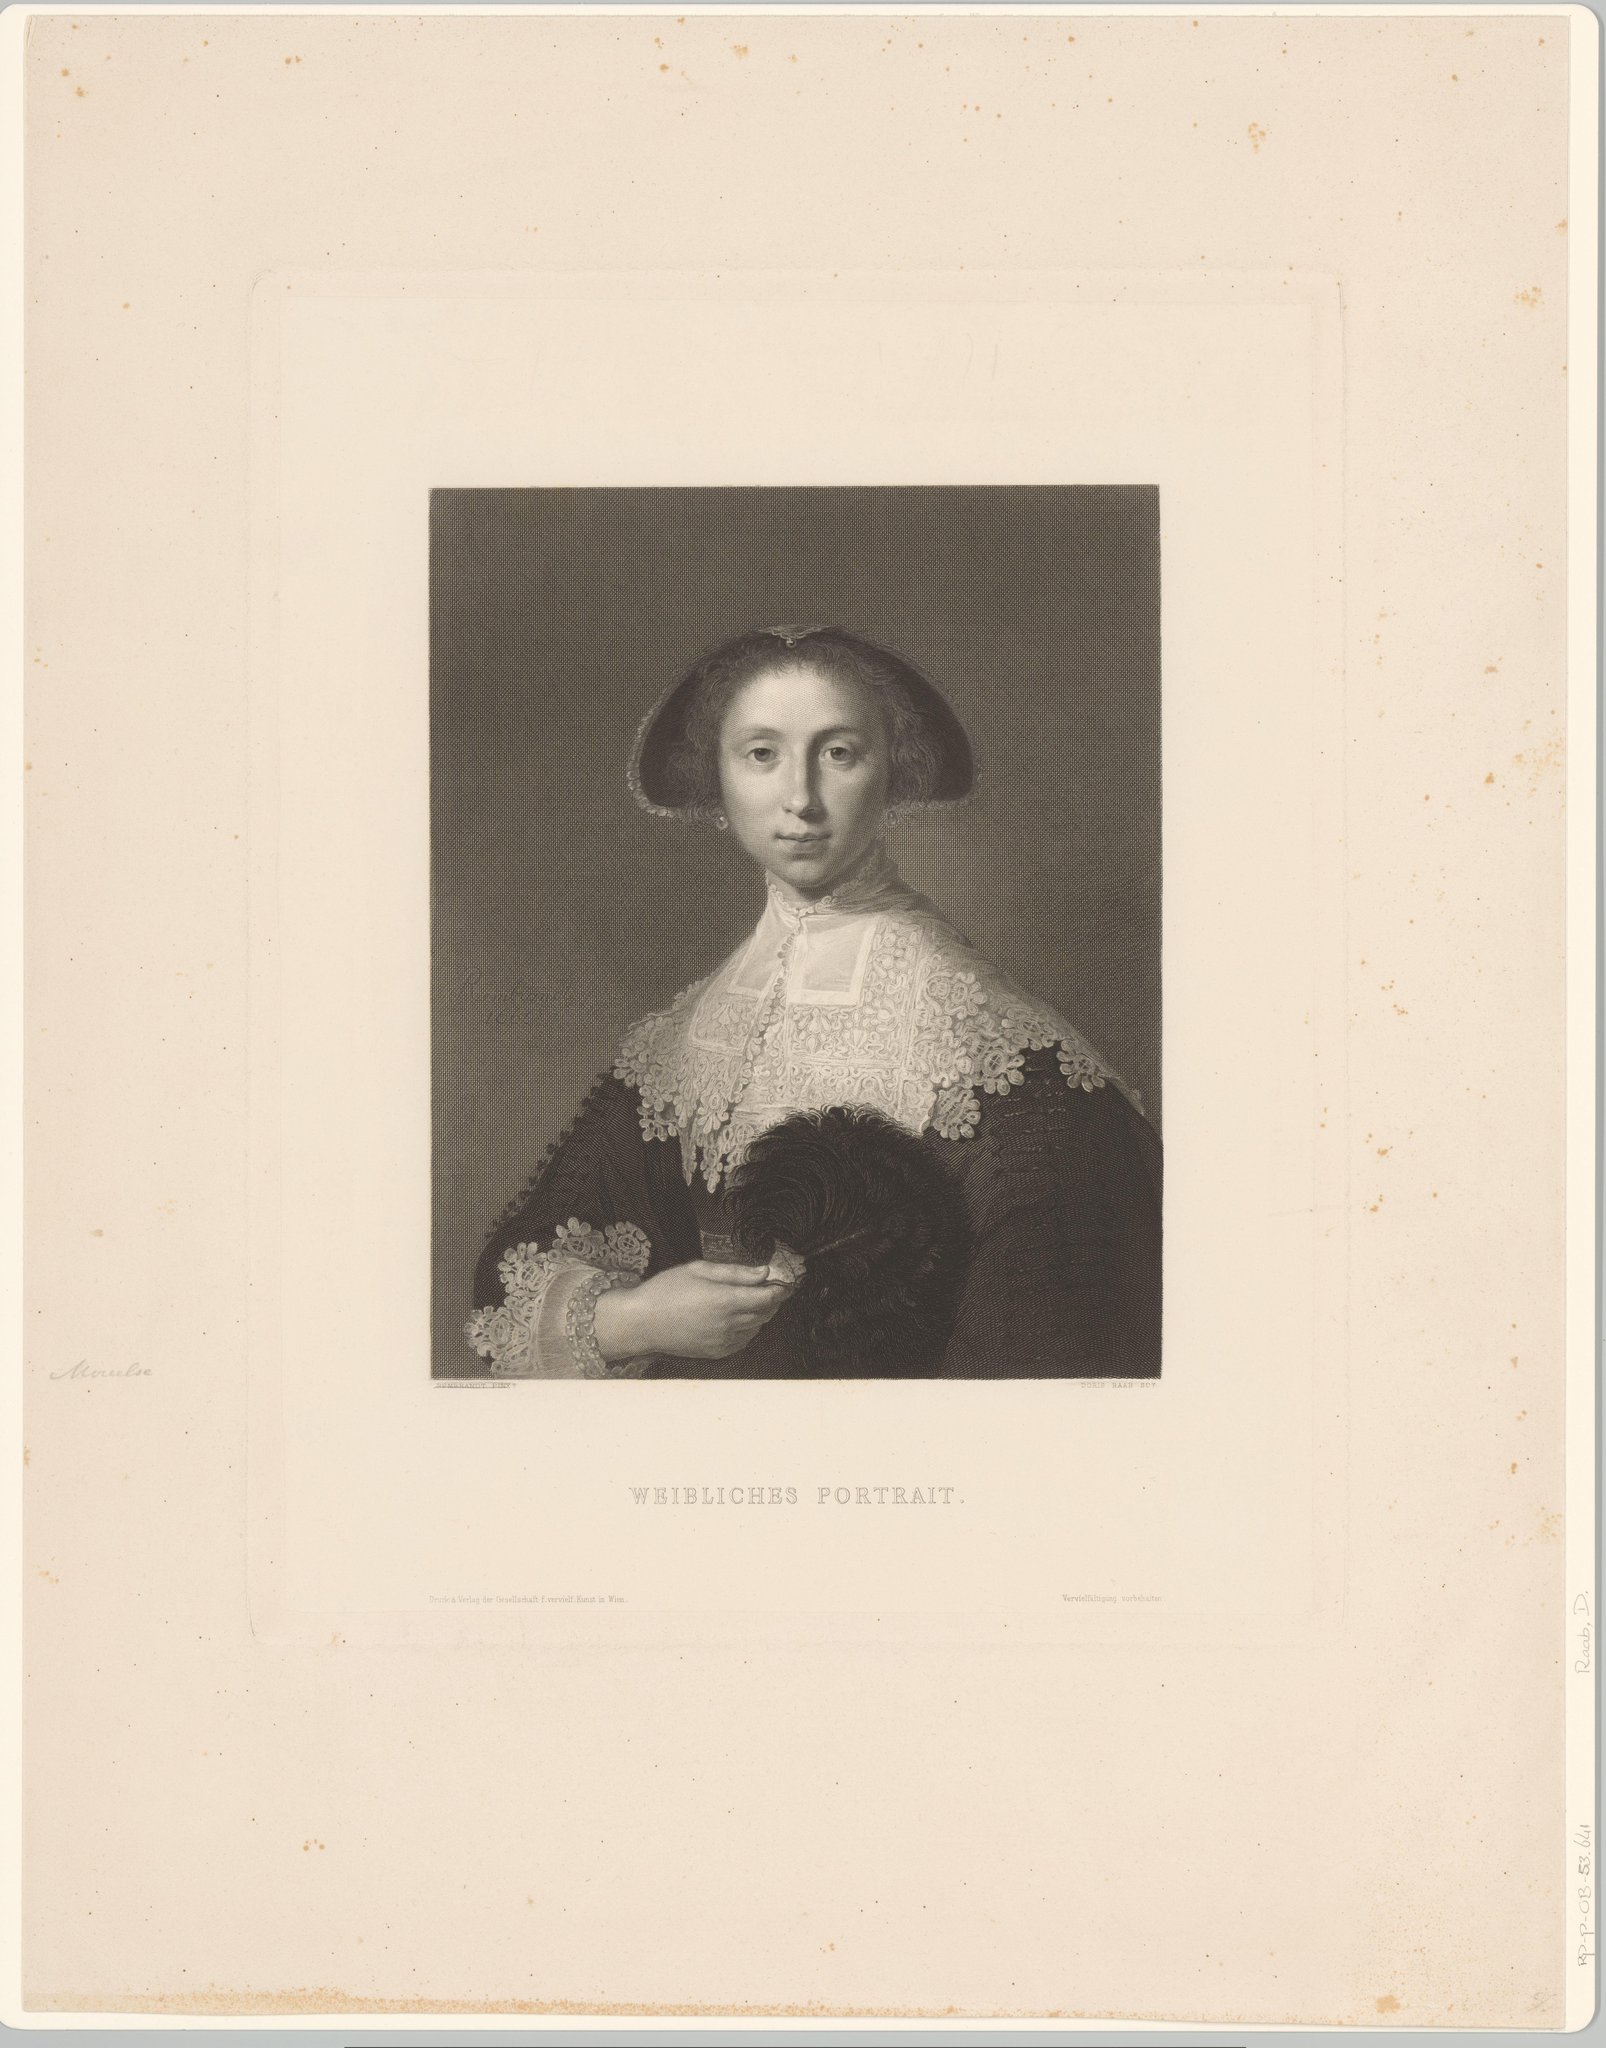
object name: print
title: Portret van een onbekende vrouw met veren waaier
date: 1851-1899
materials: paper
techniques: engraving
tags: adult woman, fan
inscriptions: collector's mark: Lugt 2228